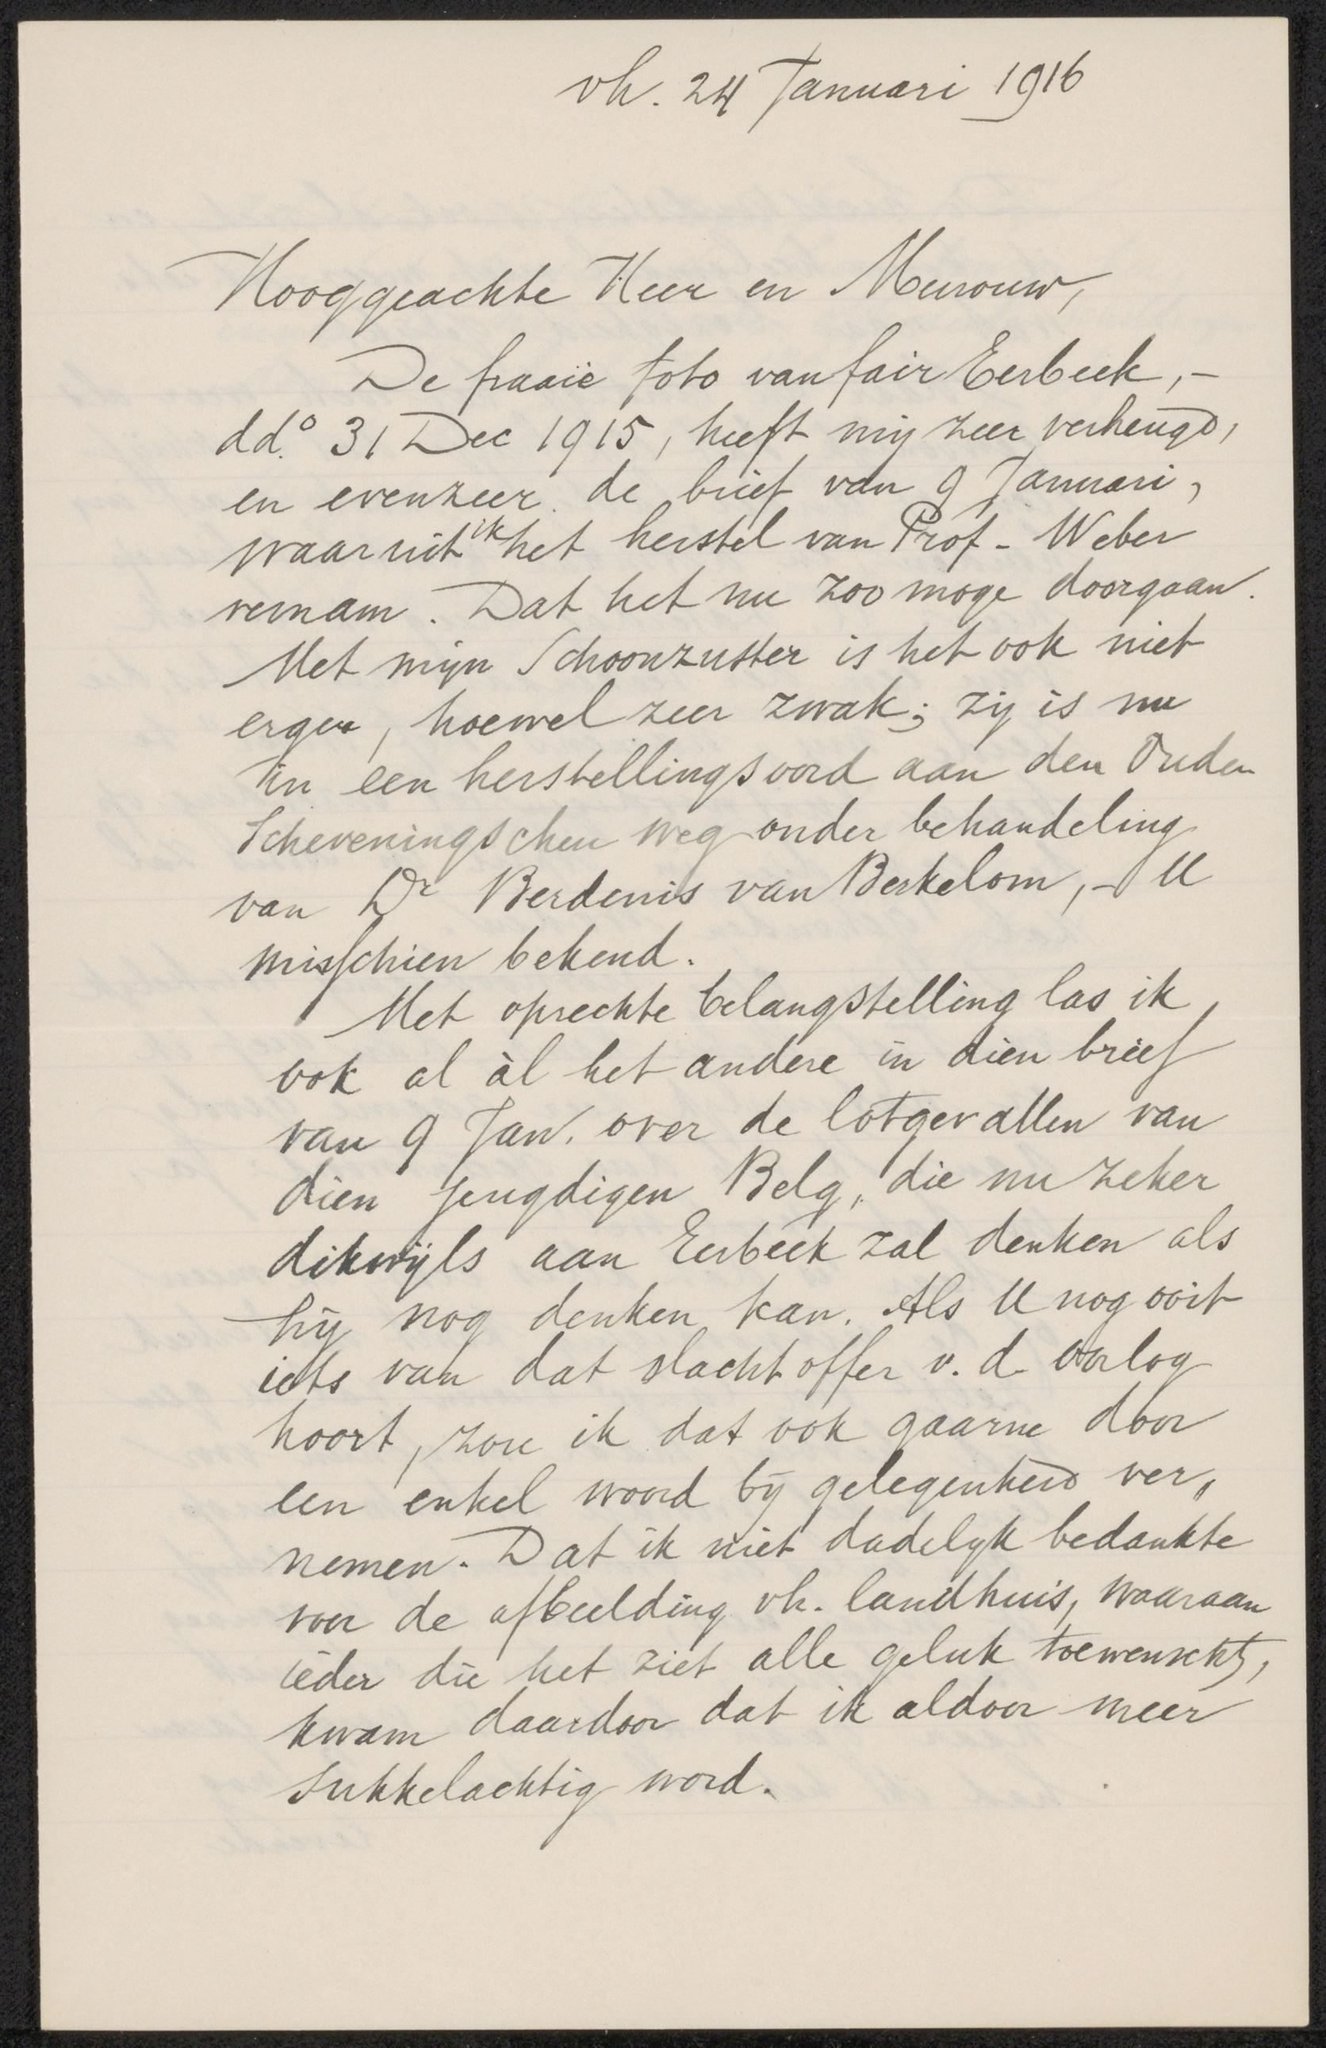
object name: letter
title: Brief aan Max Wilhelm Carl Weber en Anne Antoinette Weber-Van Bosse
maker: august allebé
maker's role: draughtsman, print maker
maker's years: 1838-1927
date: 1915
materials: ink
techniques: pen, writing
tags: anne antoinette weber-van bosse, drawing, photography, cinematography, exhibition ~ art, diseases